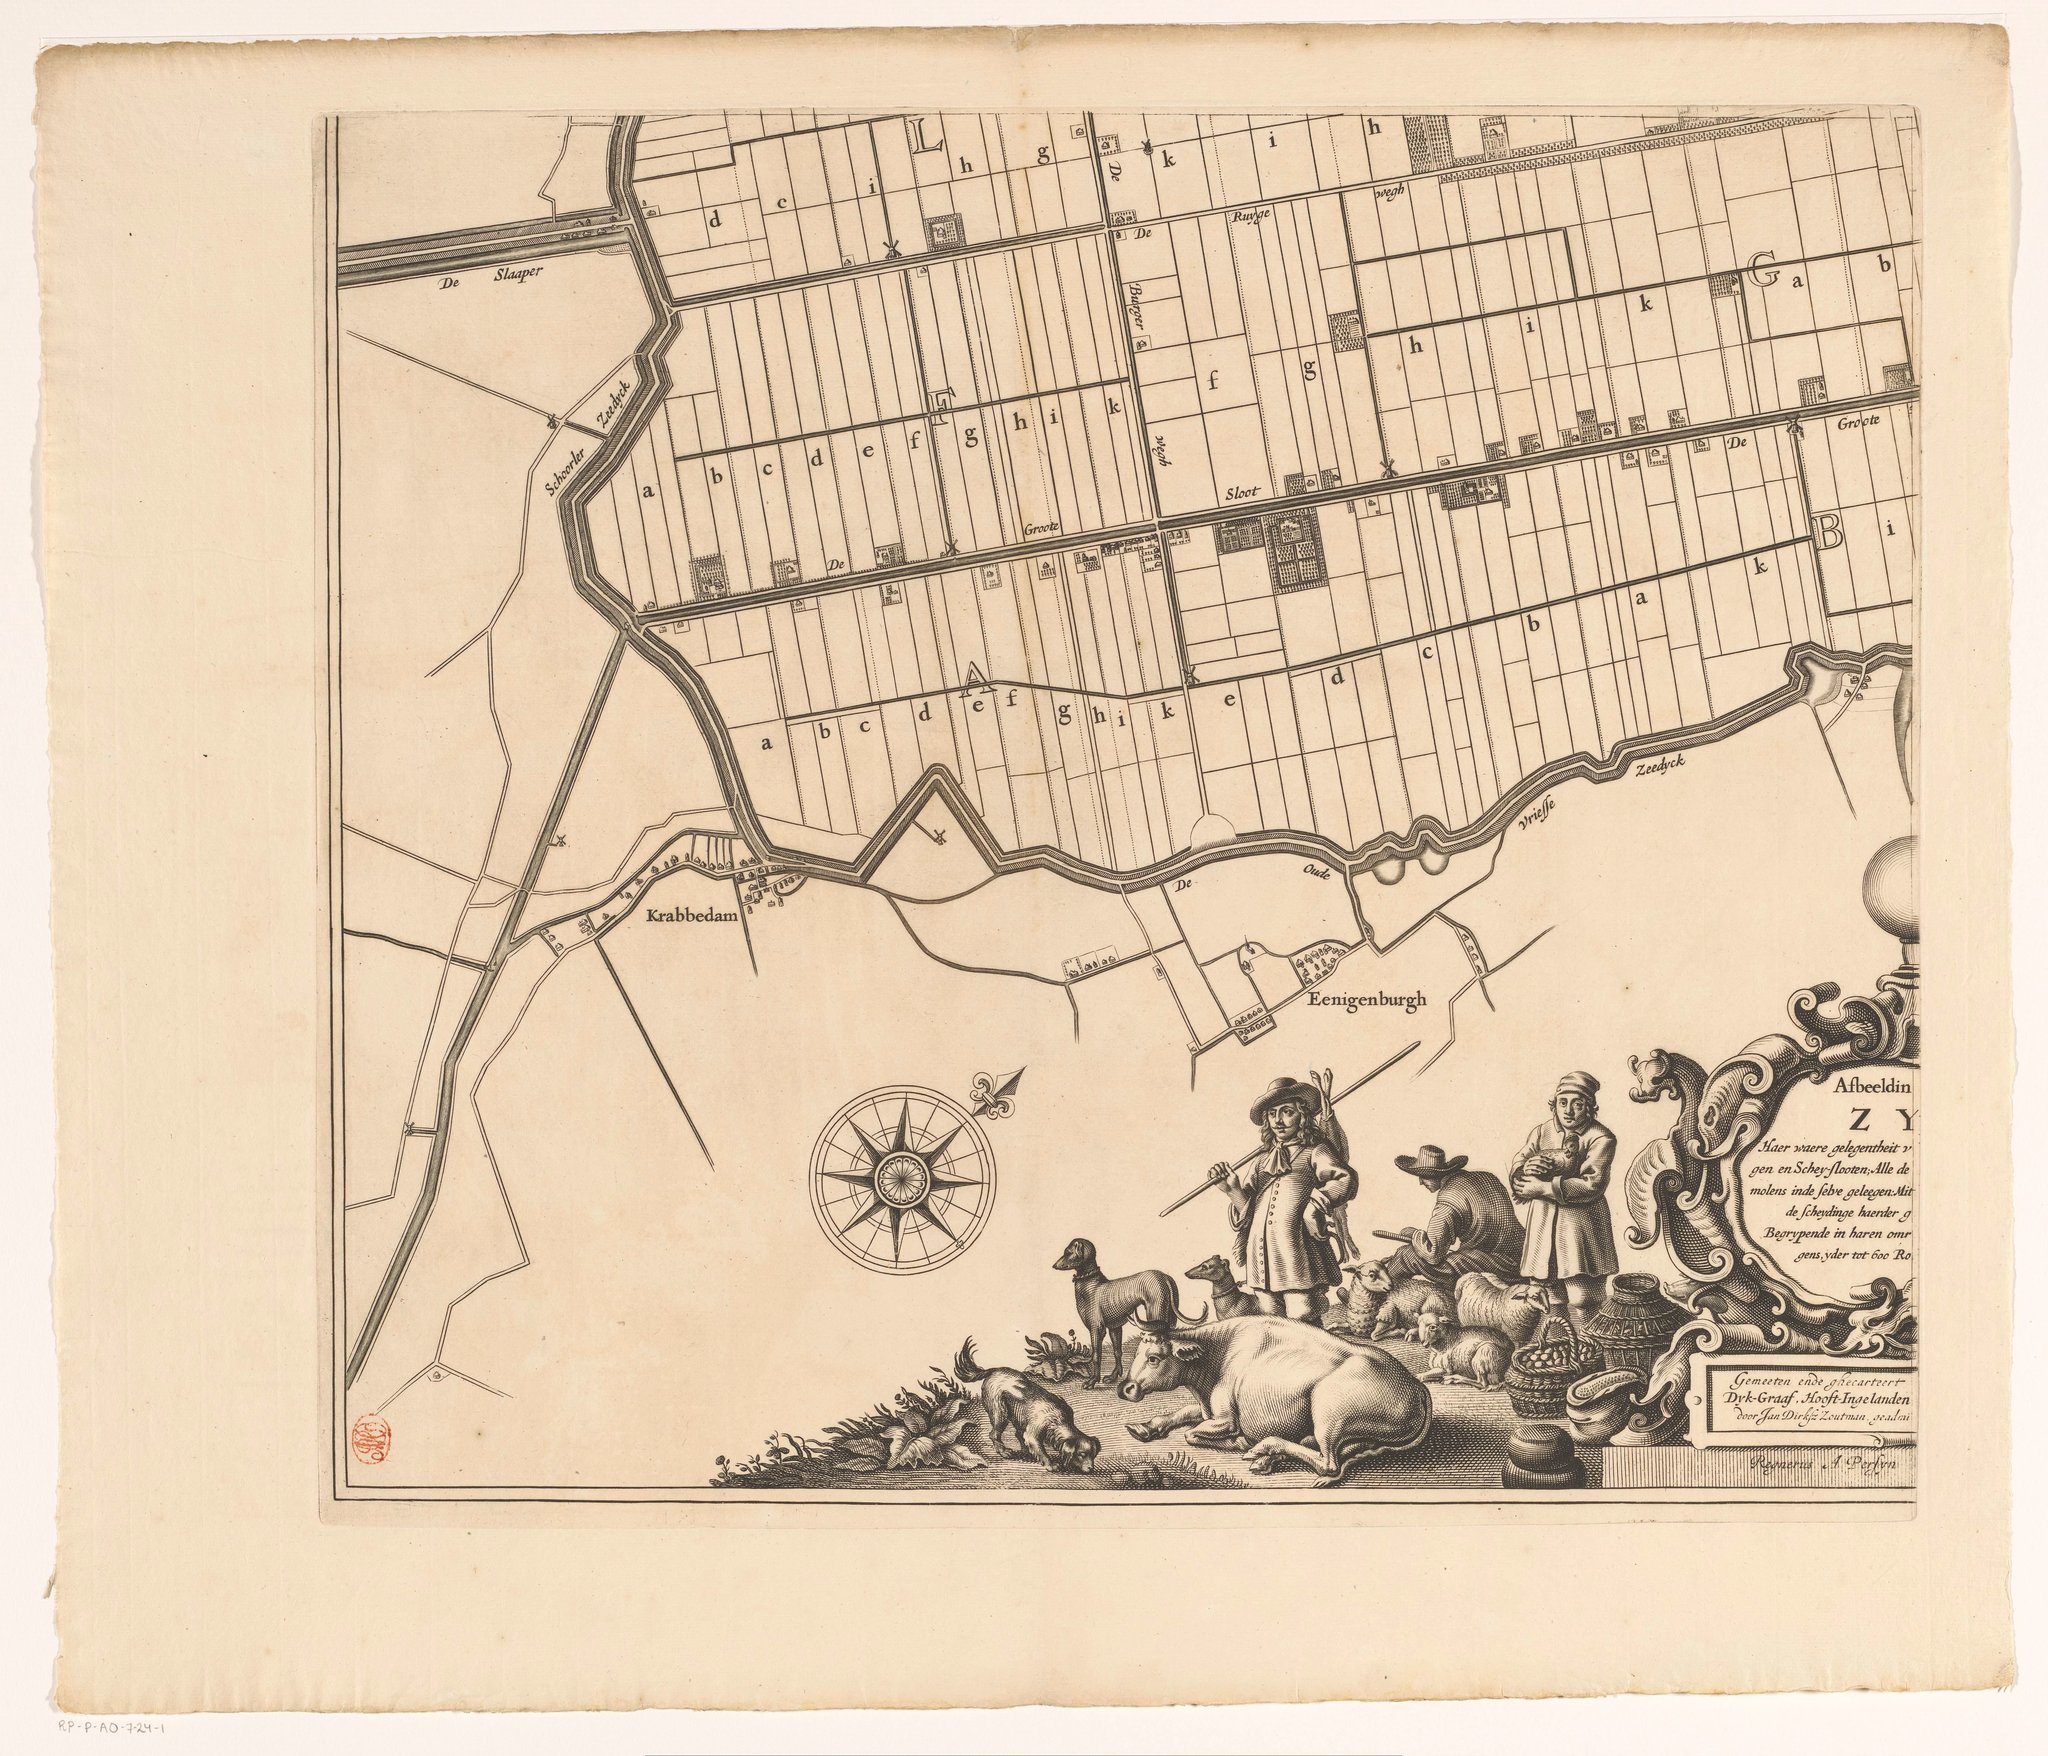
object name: map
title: Afbeelding van de Zyp. Haer waere gelegentheit van dyckage, weegen, watringen en schey-slooten; alle de hofsteden, wooningen en watermolens inde selve geleegen: mitsgaders rechte aenwysinge van de scheydinge haerder groote en kleyne letteren. Begrypende in haren omring de somme van 9060 morgens, yder tot 600 Roeden Hontsbosscher maet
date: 1665-1760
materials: paper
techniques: engraving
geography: gouda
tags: maps of separate countries or regions, cattle, hunter, farmers, polder, reclaimed land, cheese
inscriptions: collector's mark: Lugt 195, collector's mark: Lugt 2228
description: Deel (linksonder) van een kaart van de Zijpepolder.